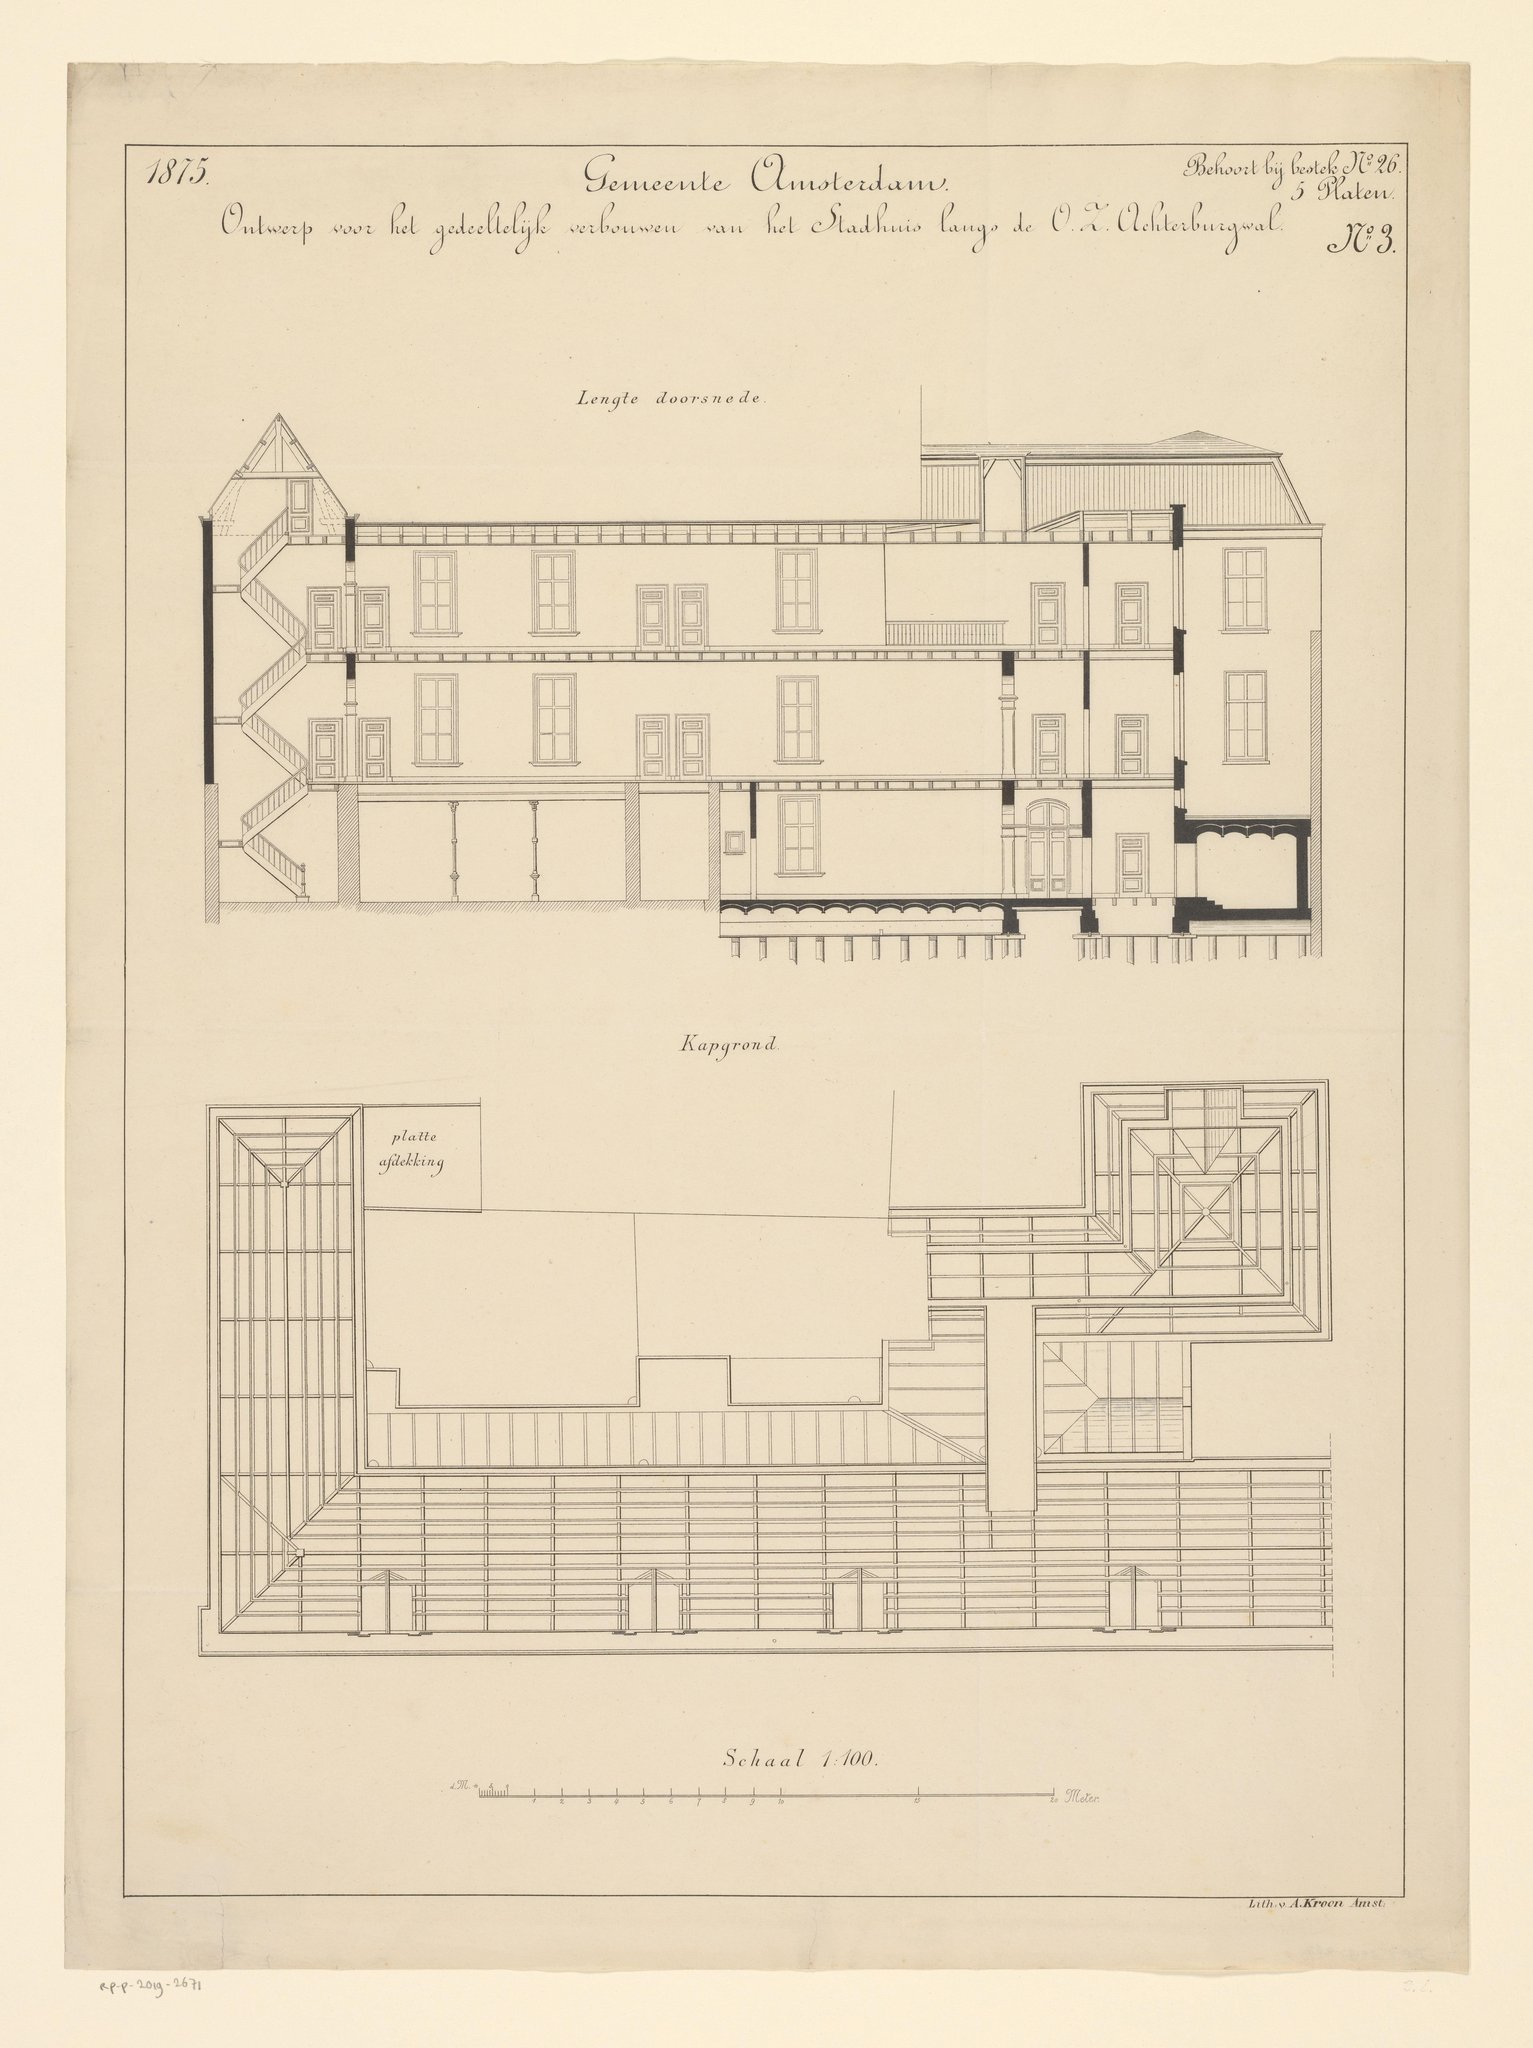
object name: print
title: Ontwerp van een gedeelte van het Stadhuis te Amsterdam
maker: a. kroon (steendrukker)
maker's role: steendrukker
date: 1875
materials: paper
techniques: lithograph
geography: amsterdam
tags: townhall, architectural design or model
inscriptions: collector's mark: Lugt 2228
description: Lengte doorsnede en kapgrond van het Stadhuis te Amsterdam.